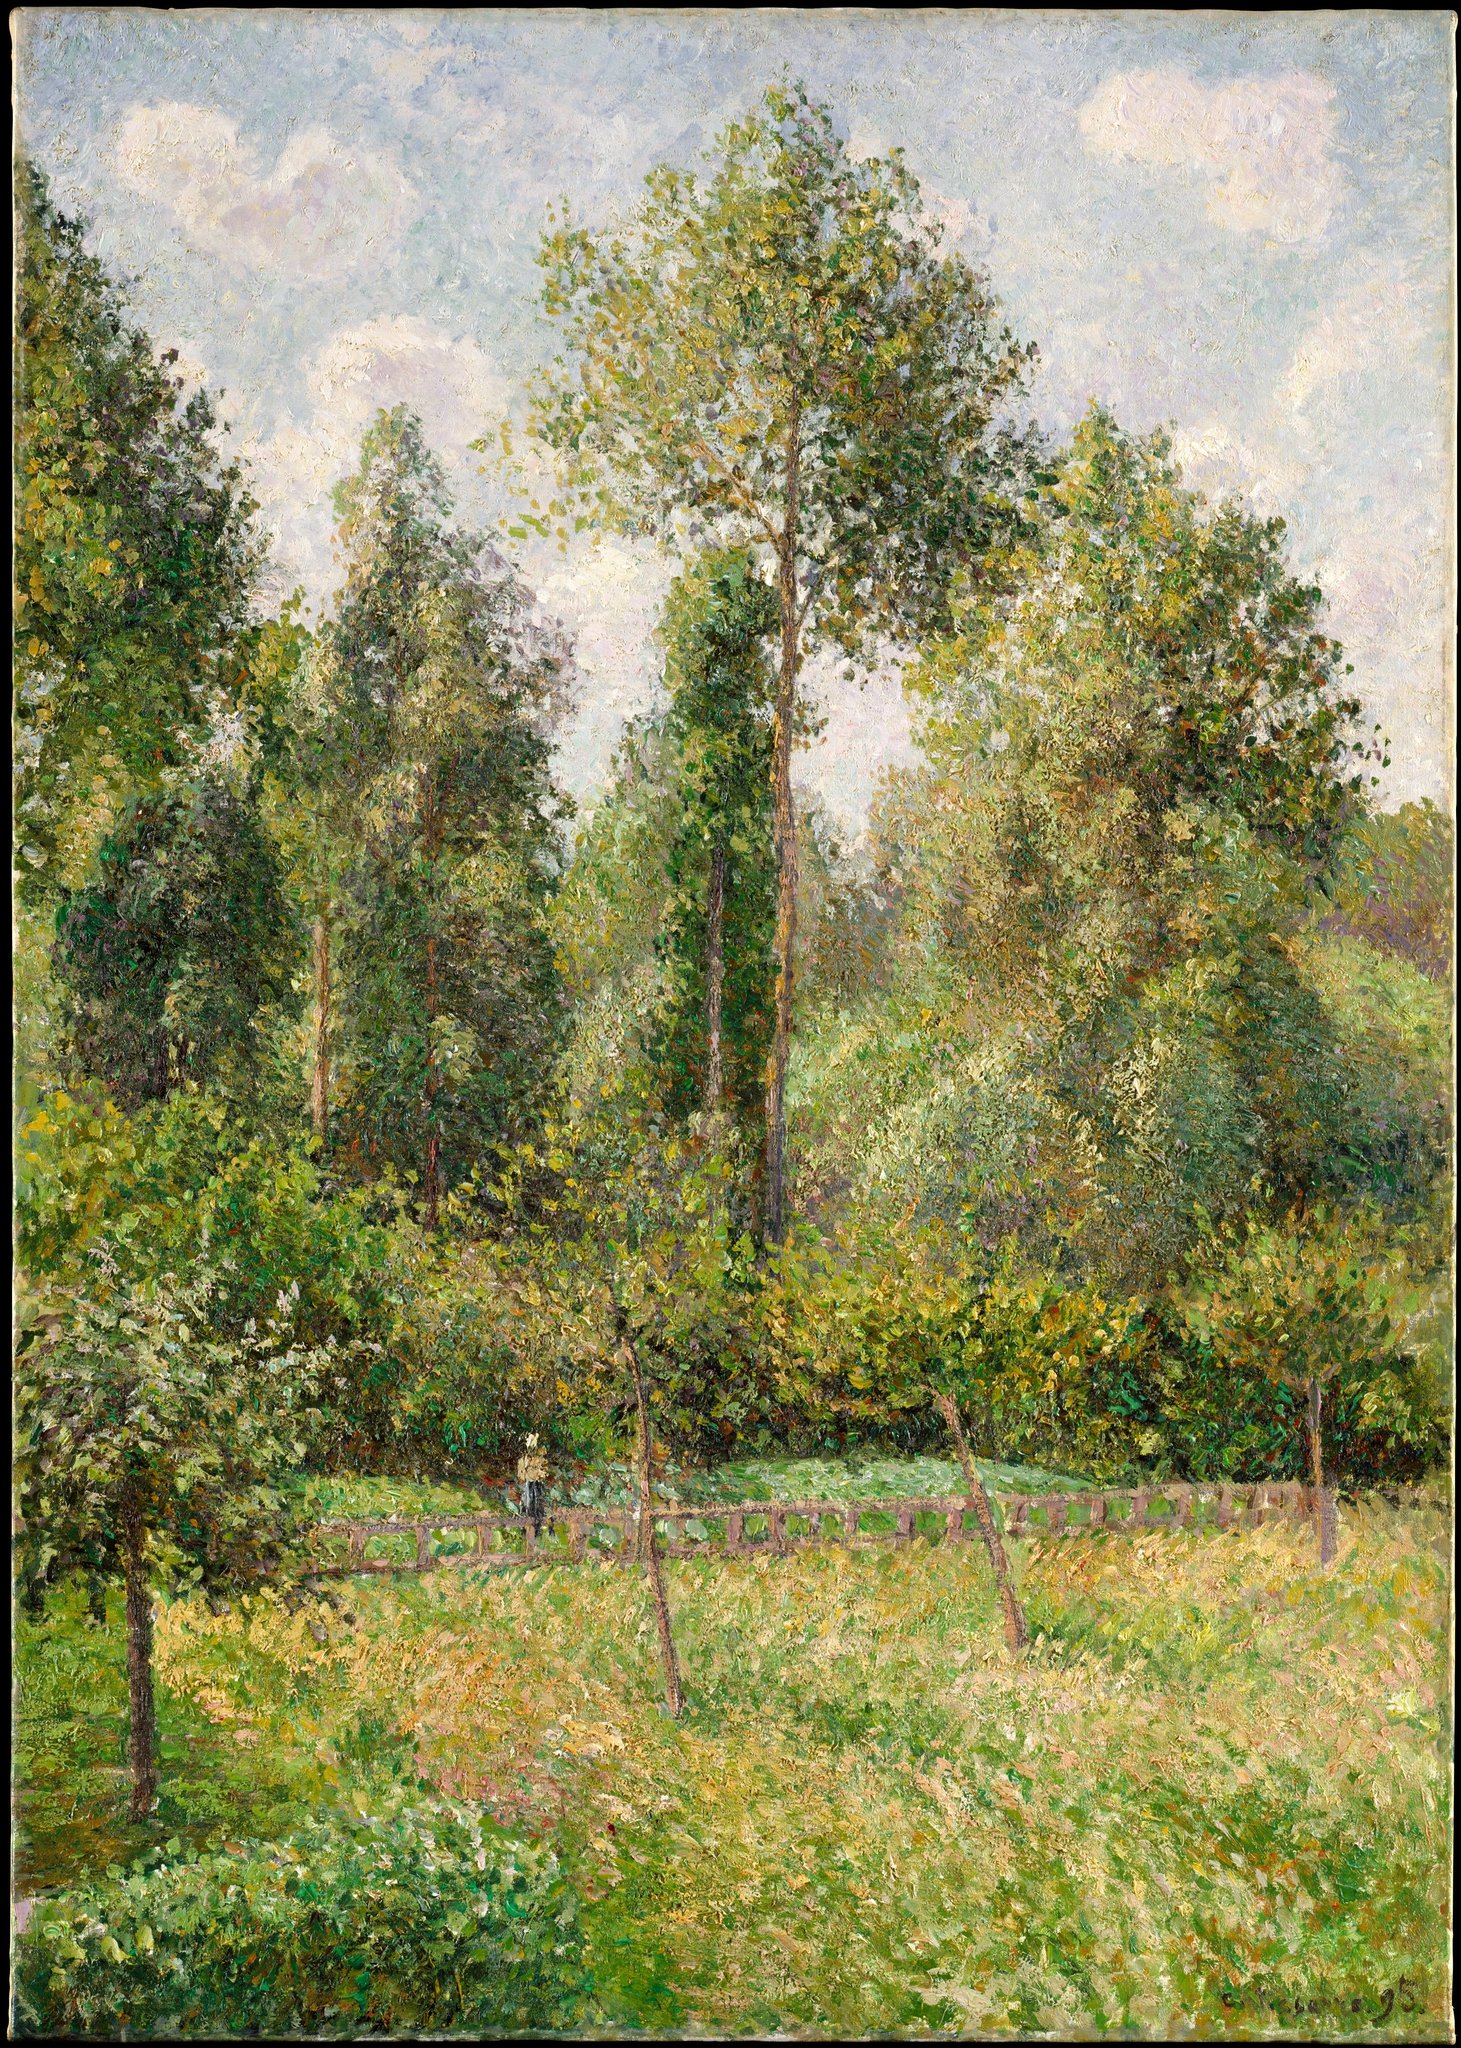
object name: painting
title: Poplars, Eragny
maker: camille pissarro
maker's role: artist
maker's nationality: french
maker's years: 1830-1903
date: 1895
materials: canvas, oil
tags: gardens,landscapes